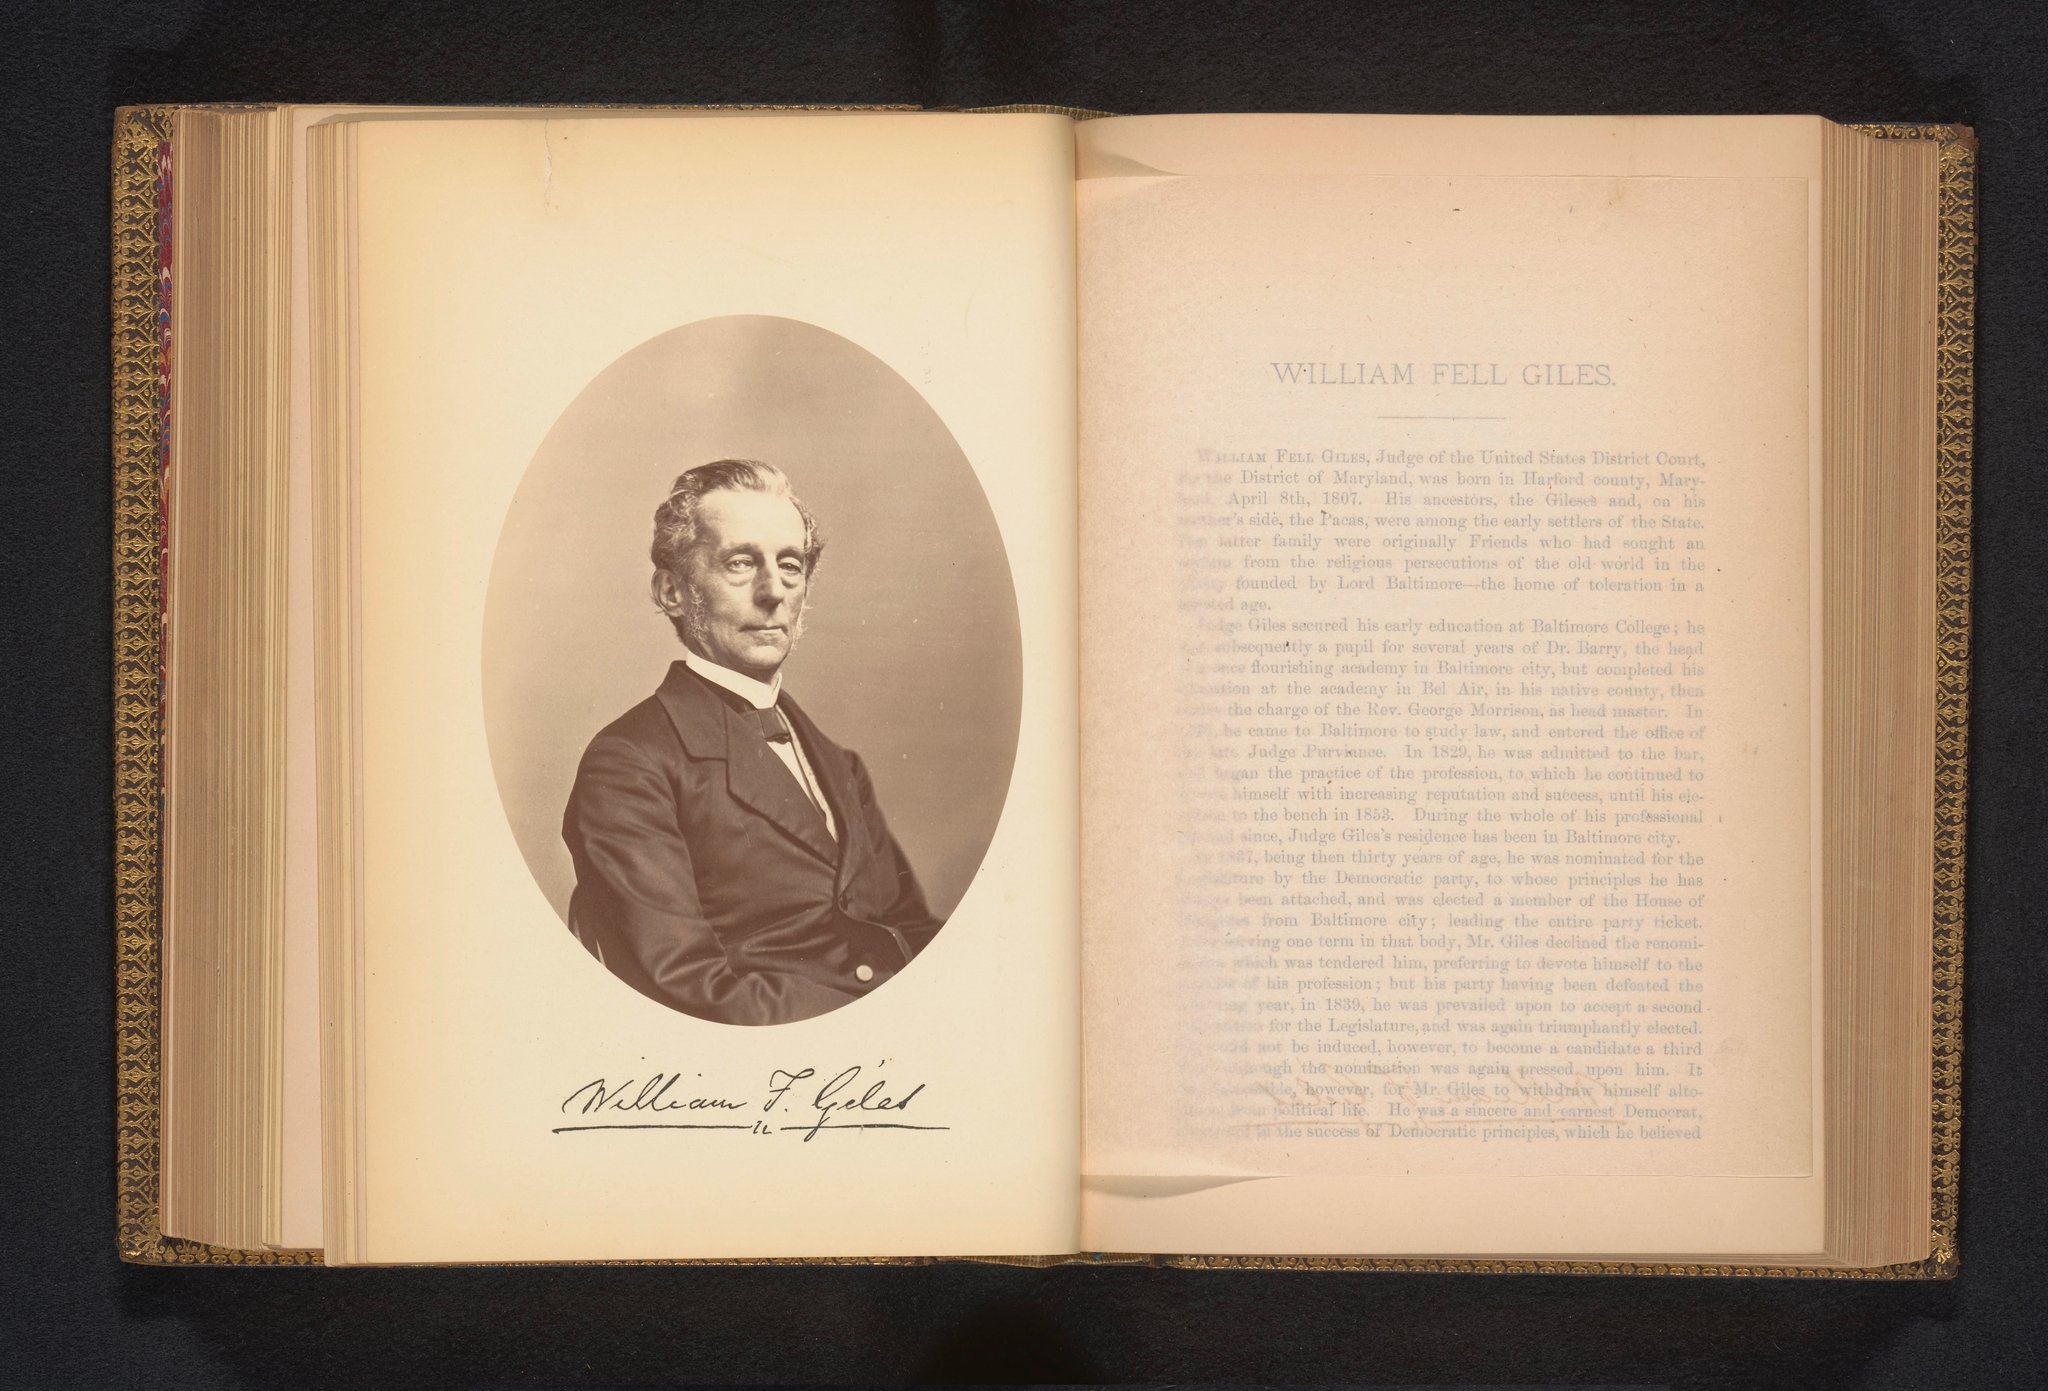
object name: page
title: William F. Giles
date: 1866-1871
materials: photographic support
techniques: albumen print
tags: politician, historical persons